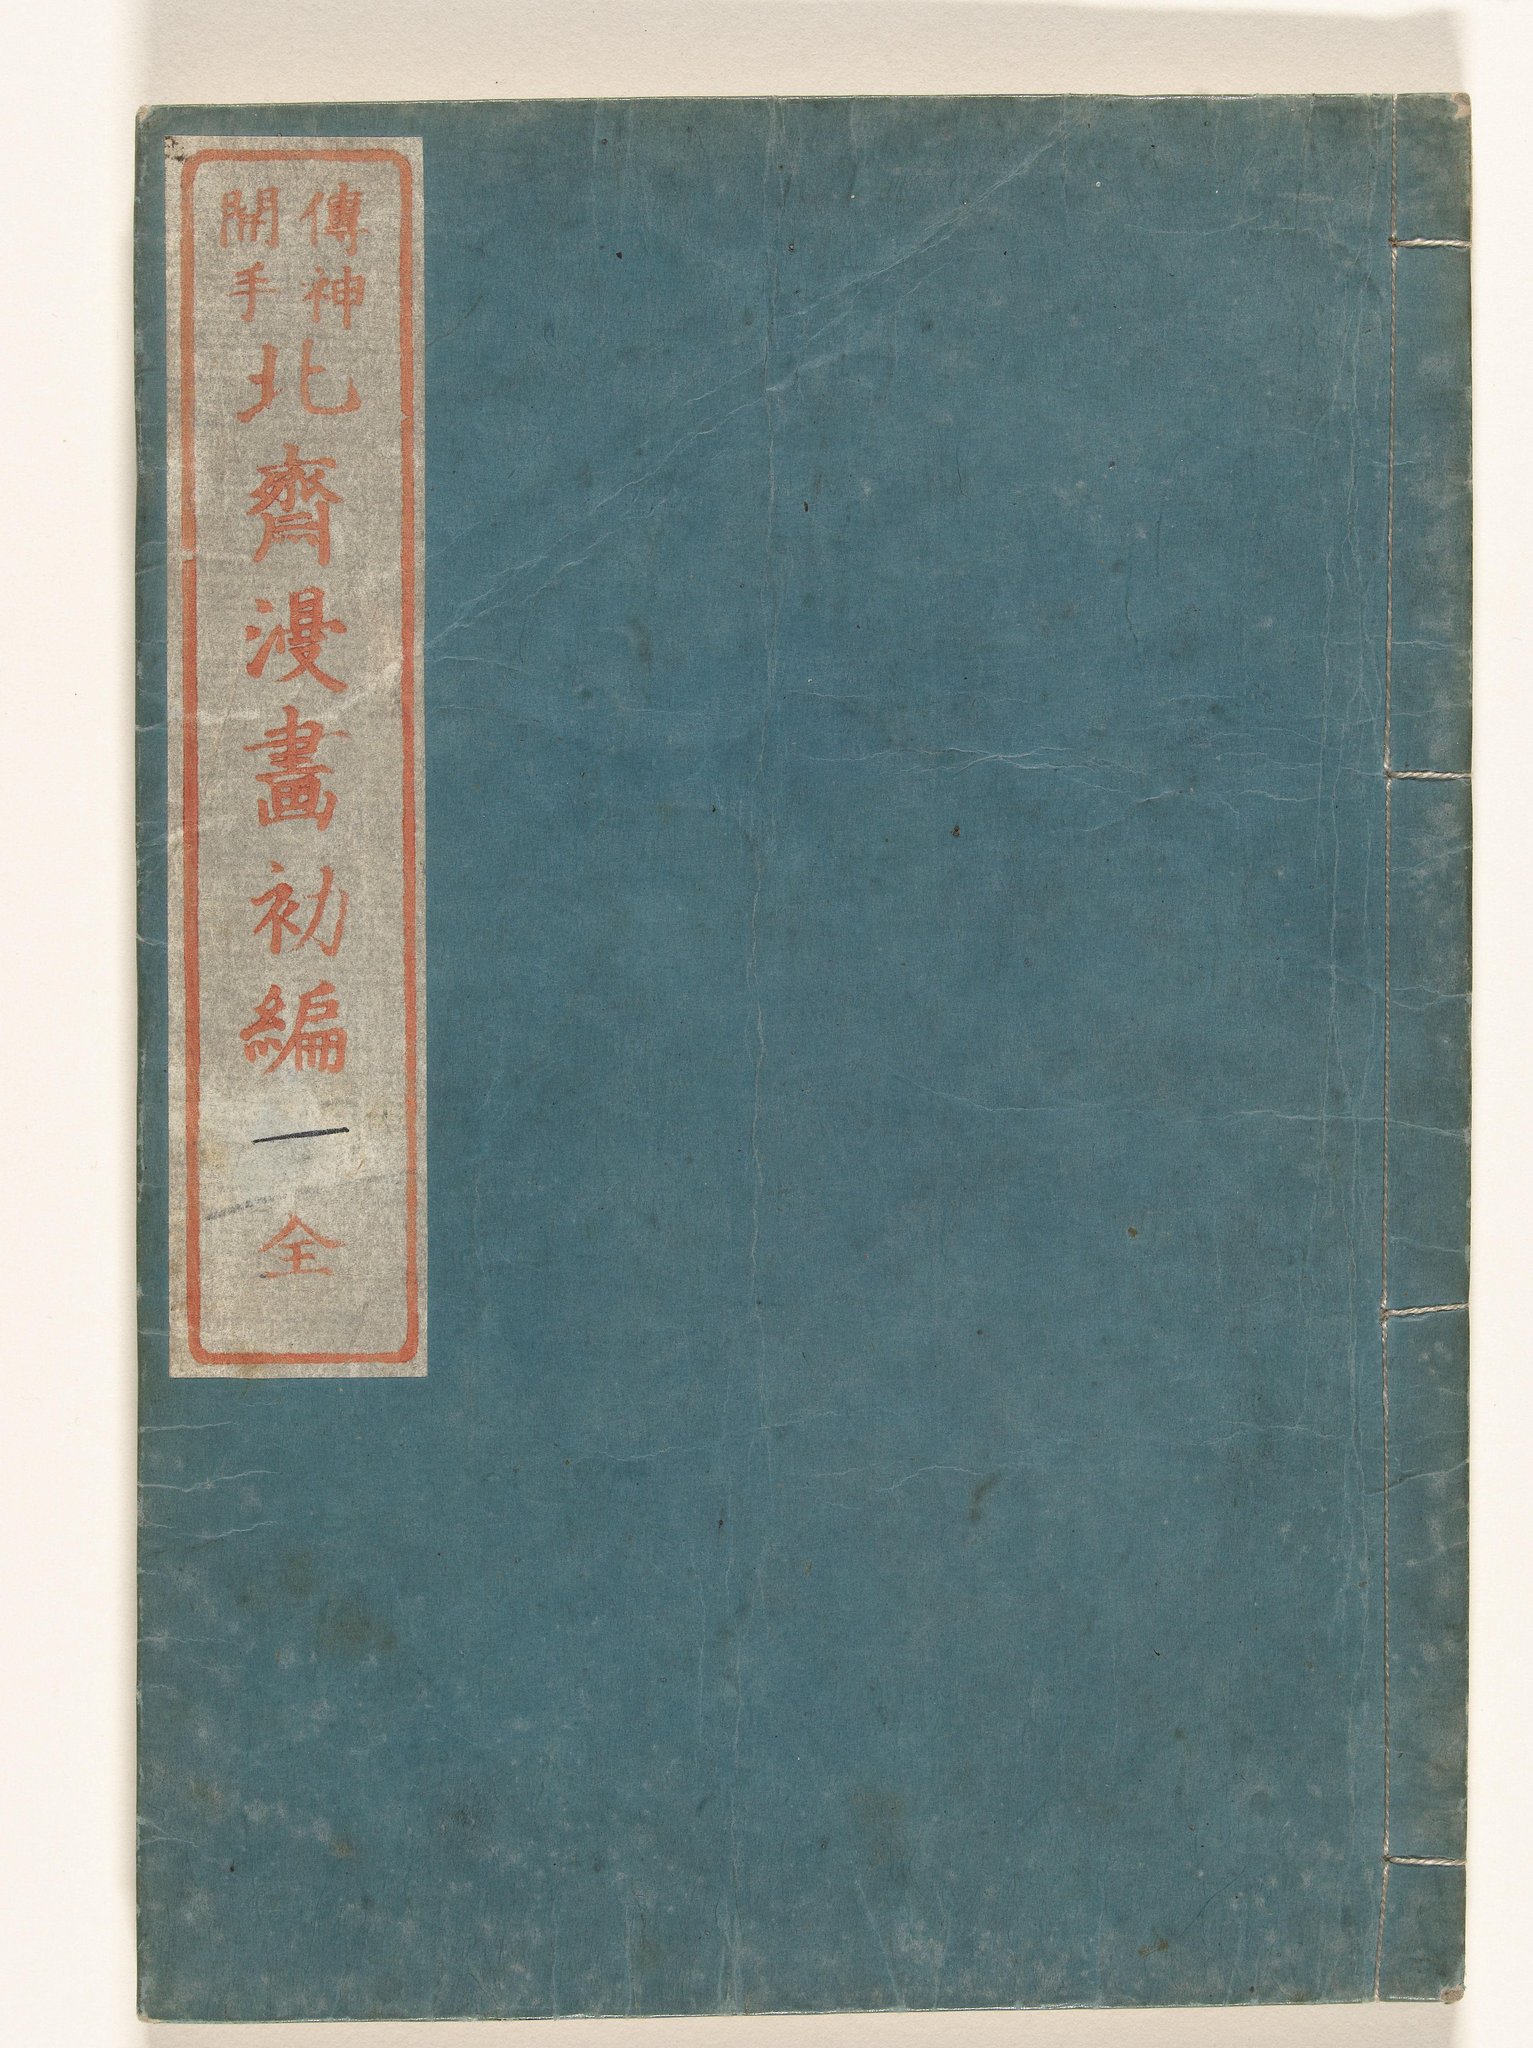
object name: book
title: Hokusai manga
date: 1819-1878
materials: paper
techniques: woodcut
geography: nagoya